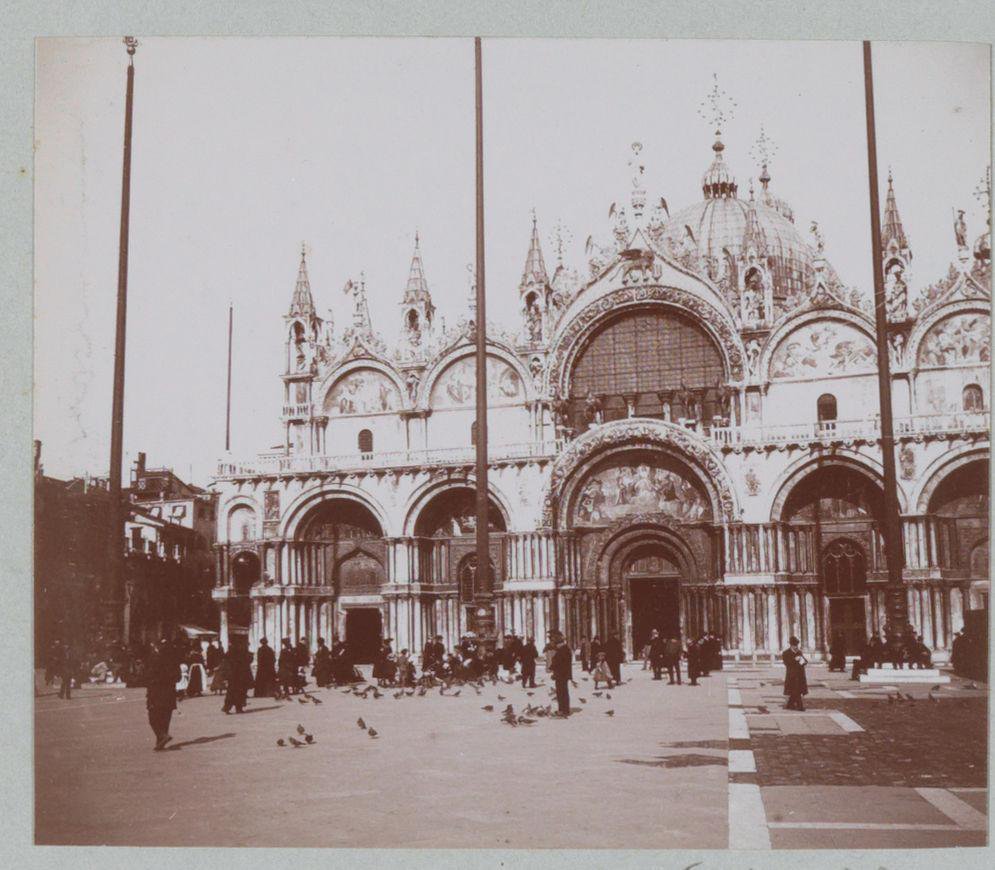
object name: photograph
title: Basiliek van San Marco aan het San Marcoplein in Venetië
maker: Anonymous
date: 1905-1910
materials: paper, photographic support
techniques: gelatin silver print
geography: venice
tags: church (exterior), square, place, circus, etc. (+ city(-scape) with figures, staffage), venice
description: Onderdeel van Fotoalbum van een Franse amateurfotograaf met bezienswaardigheden in Frankrijk, Zwitserland en Italië.